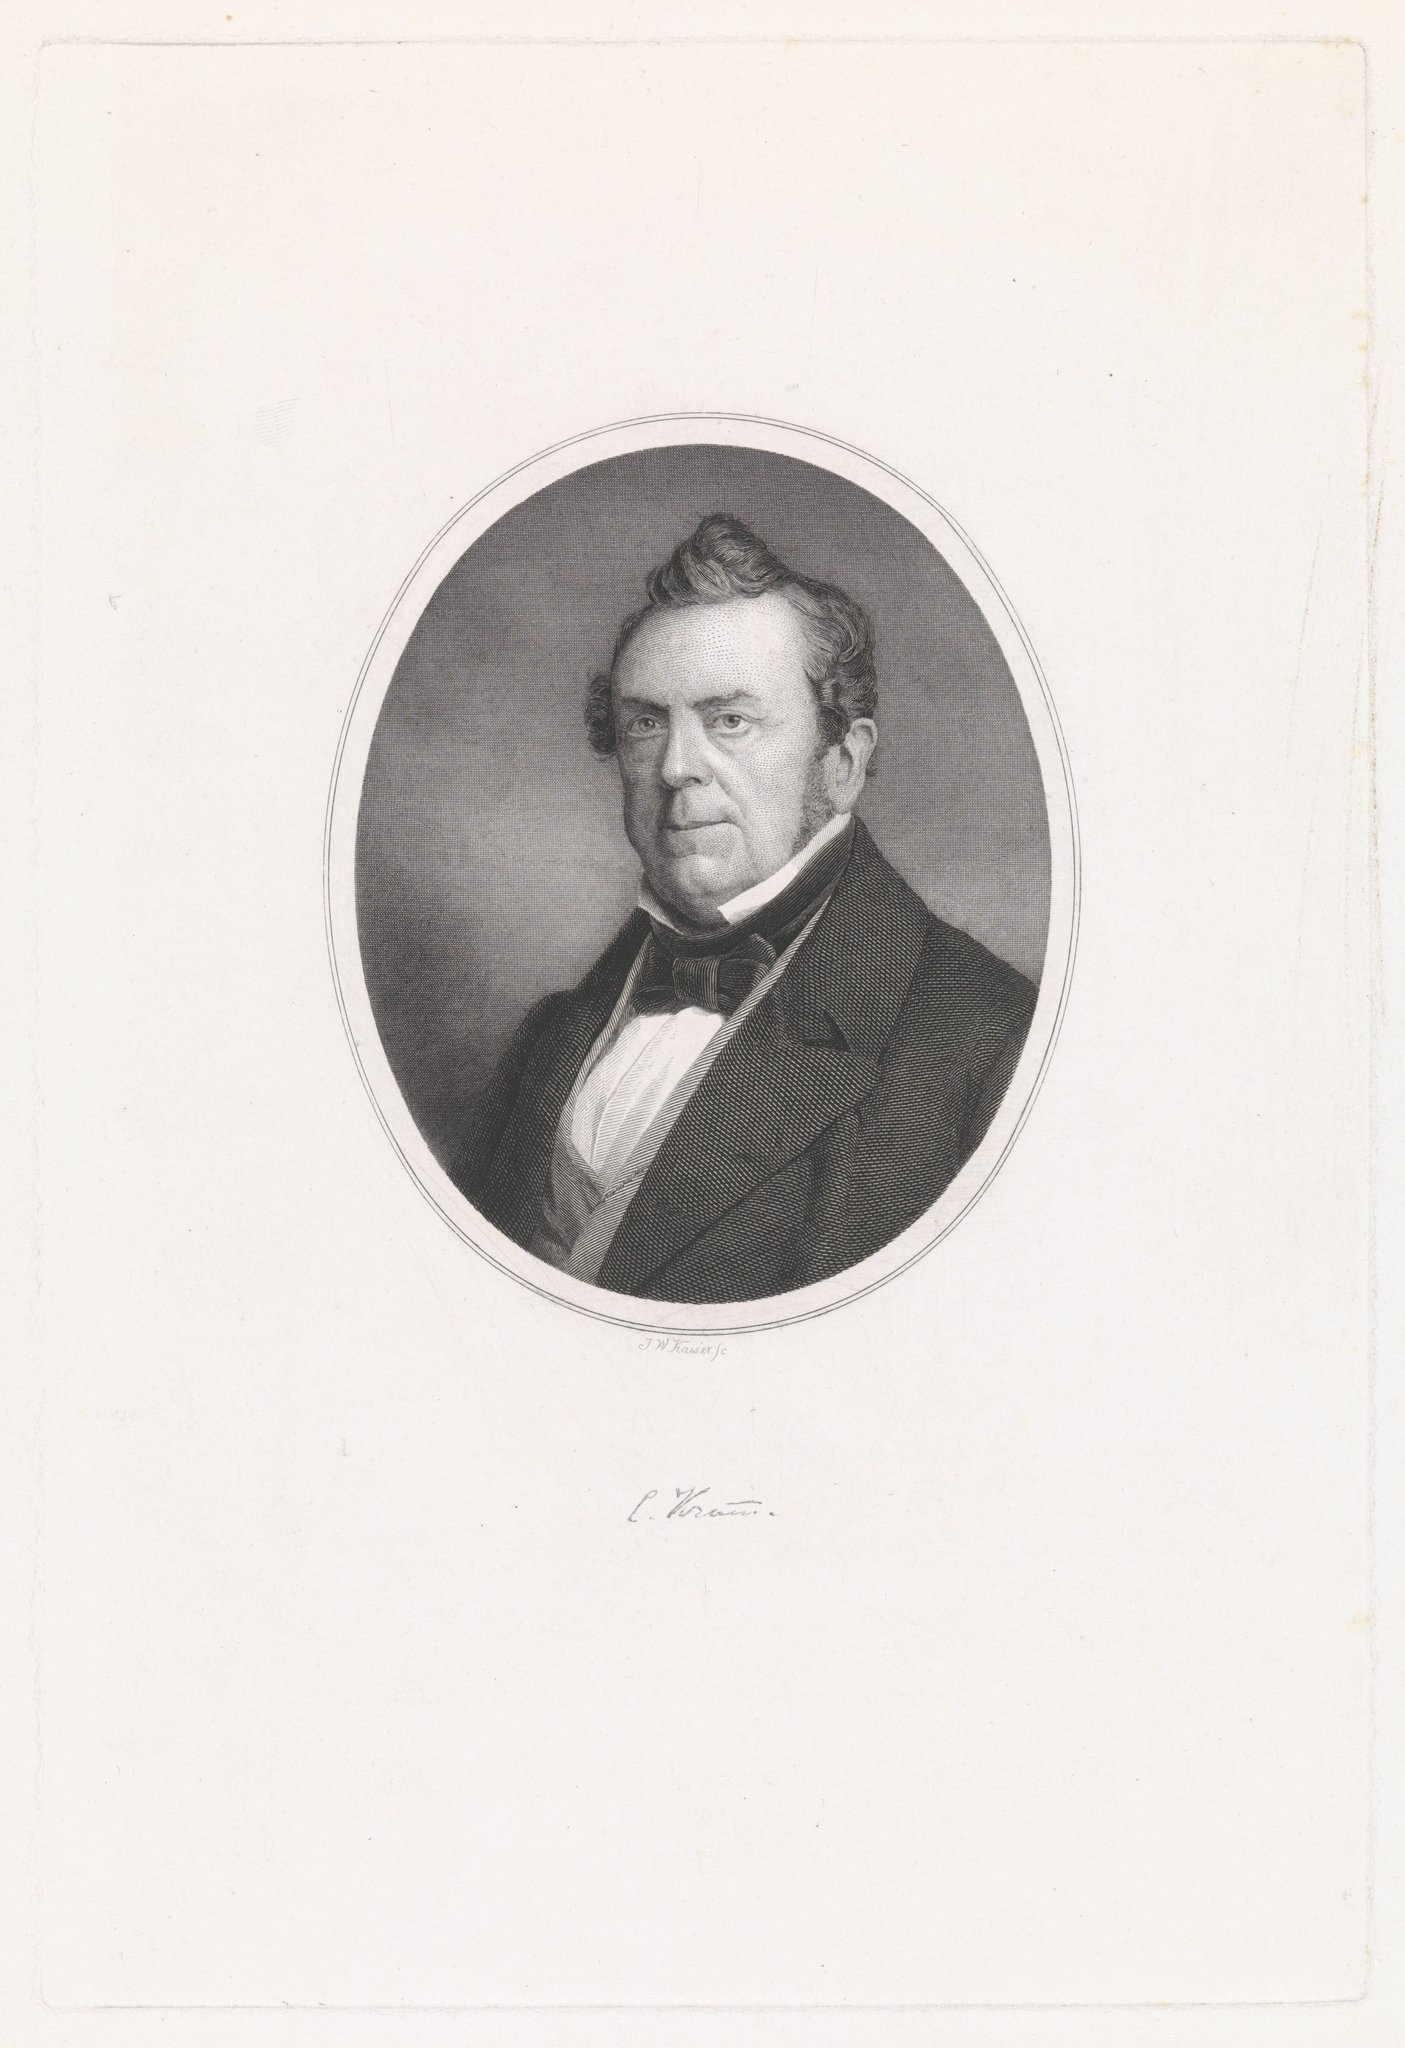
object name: print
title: Portret van Christiaan Kramm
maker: johann wilhelm kaiser (i)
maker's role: draughtsman, print maker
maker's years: 1813-1900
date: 1864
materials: paper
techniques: etching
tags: utrecht, print maker, draughtsman, christiaan kramm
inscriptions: collector's mark: Lugt 2228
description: Portretbuste in ovaal naar links van schrijver en beeldend kunstenaar Christiaan Kramm.